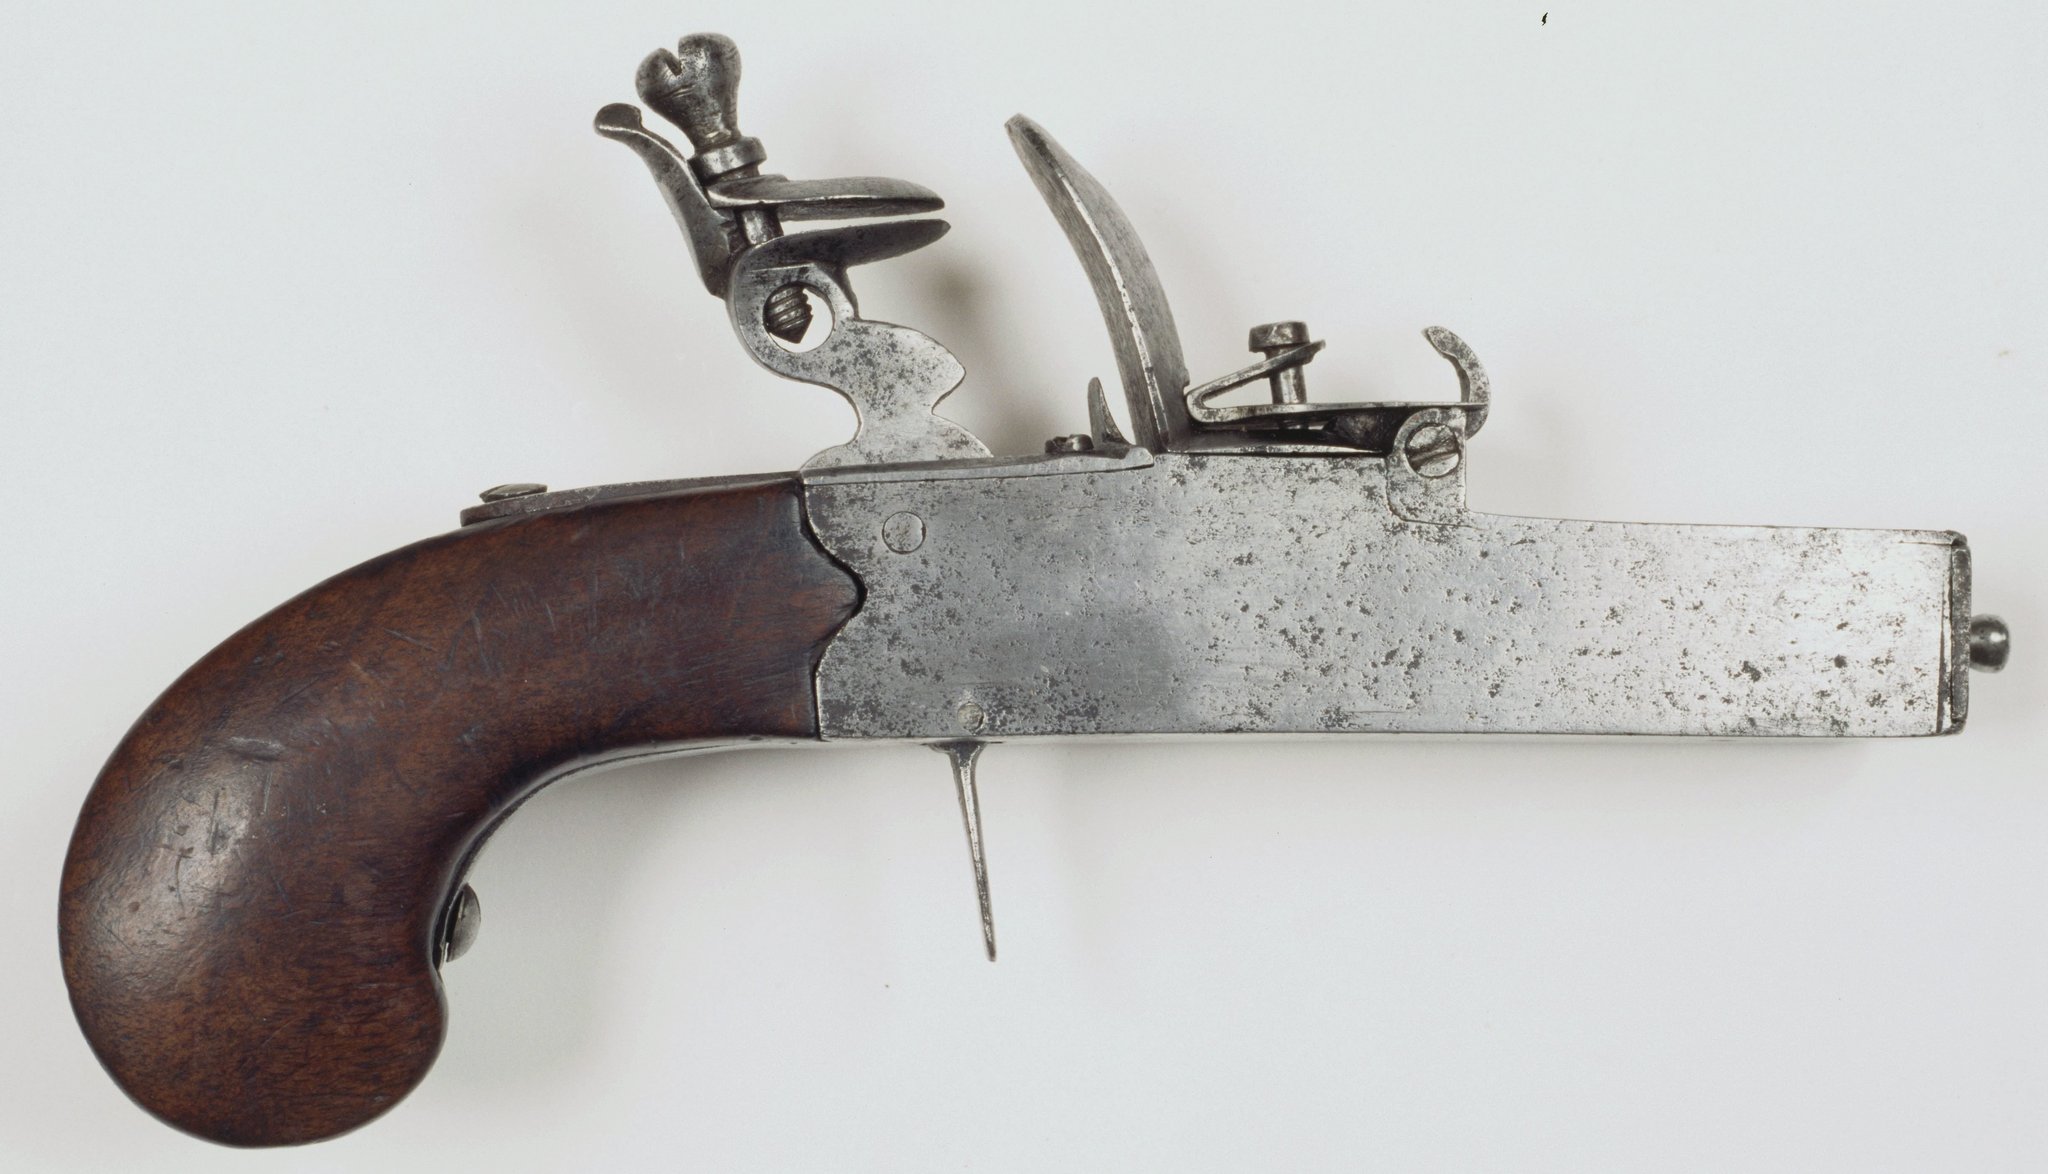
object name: tinder box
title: Pistool-tondeldoos met vuursteenslot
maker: Anonymous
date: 1860-1900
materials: iron, wood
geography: europe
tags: netherlands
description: Pistool-tondeldoos met vuursteenslot. IJzeren vierhoekige loop waar een schuifbare klep voor zit die met een ronde pin kan worden afgesloten. Bovenop de loop bevindt zich het vuurstaal welke omhoog geklapt kan worden en een ijzeren haan. De kolf is van hout en zit door middel van twee schroeven vast aan de loop. Onder de loop een rechte ijzeren trekker.